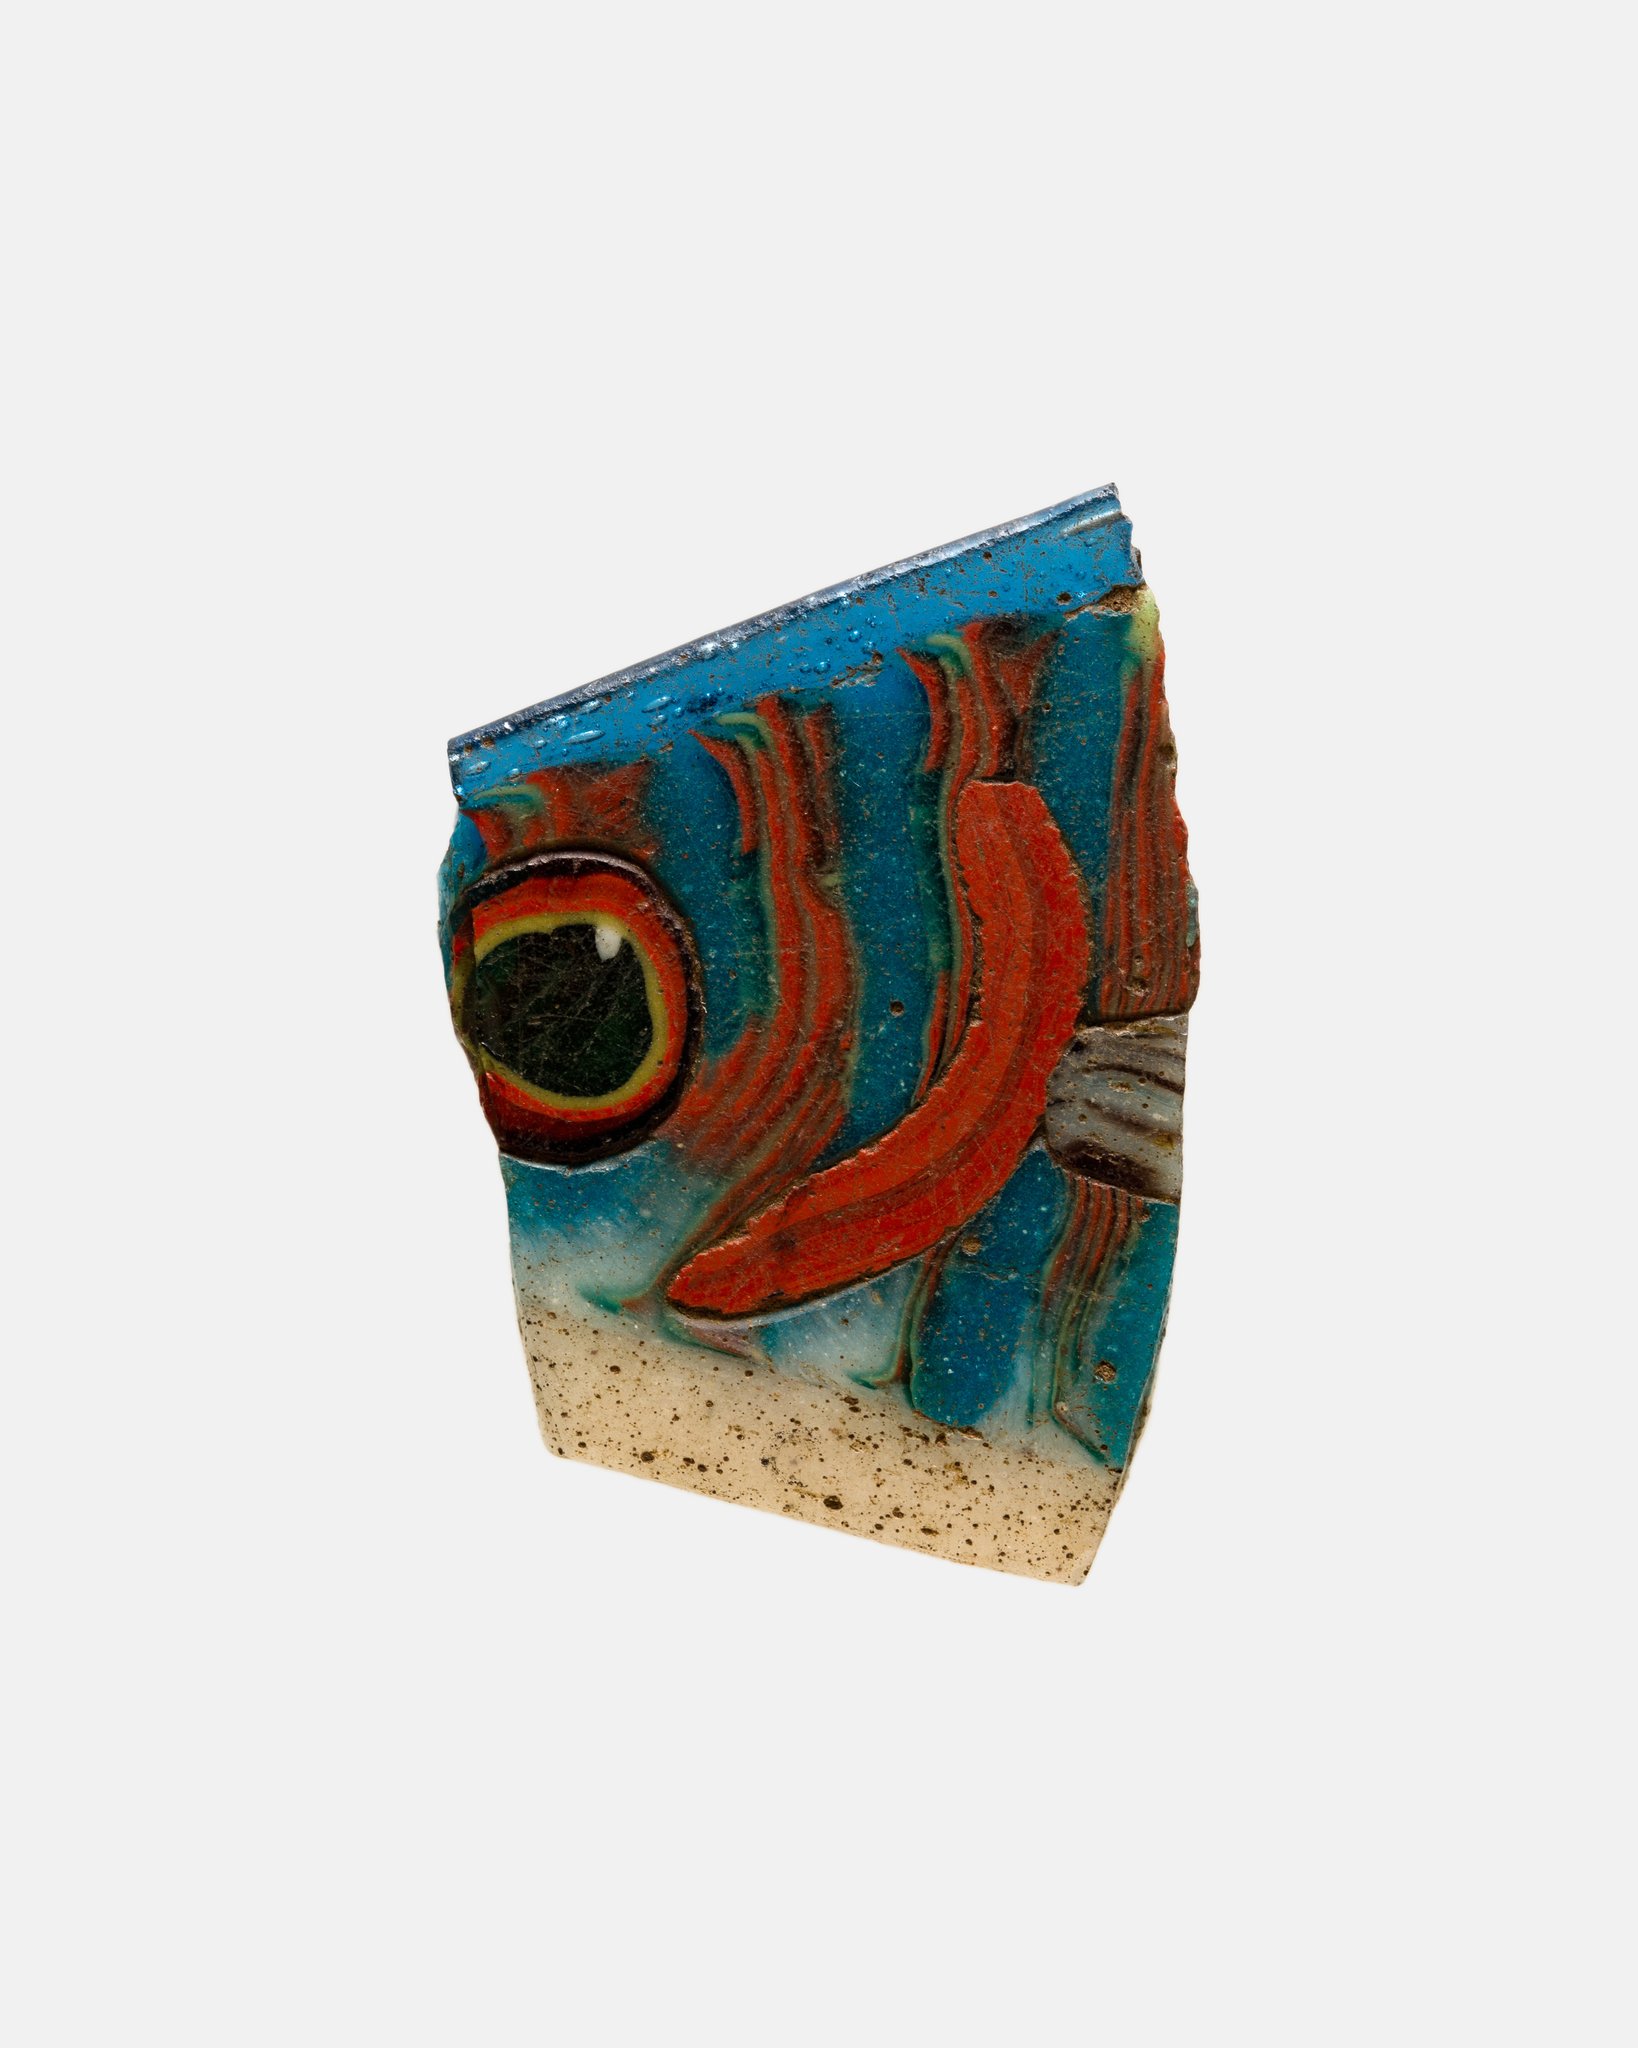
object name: inlay, fish fragment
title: Nilotic scene inlay, fish fragment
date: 200 BCE-100 CE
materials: glass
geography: egypt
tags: fish